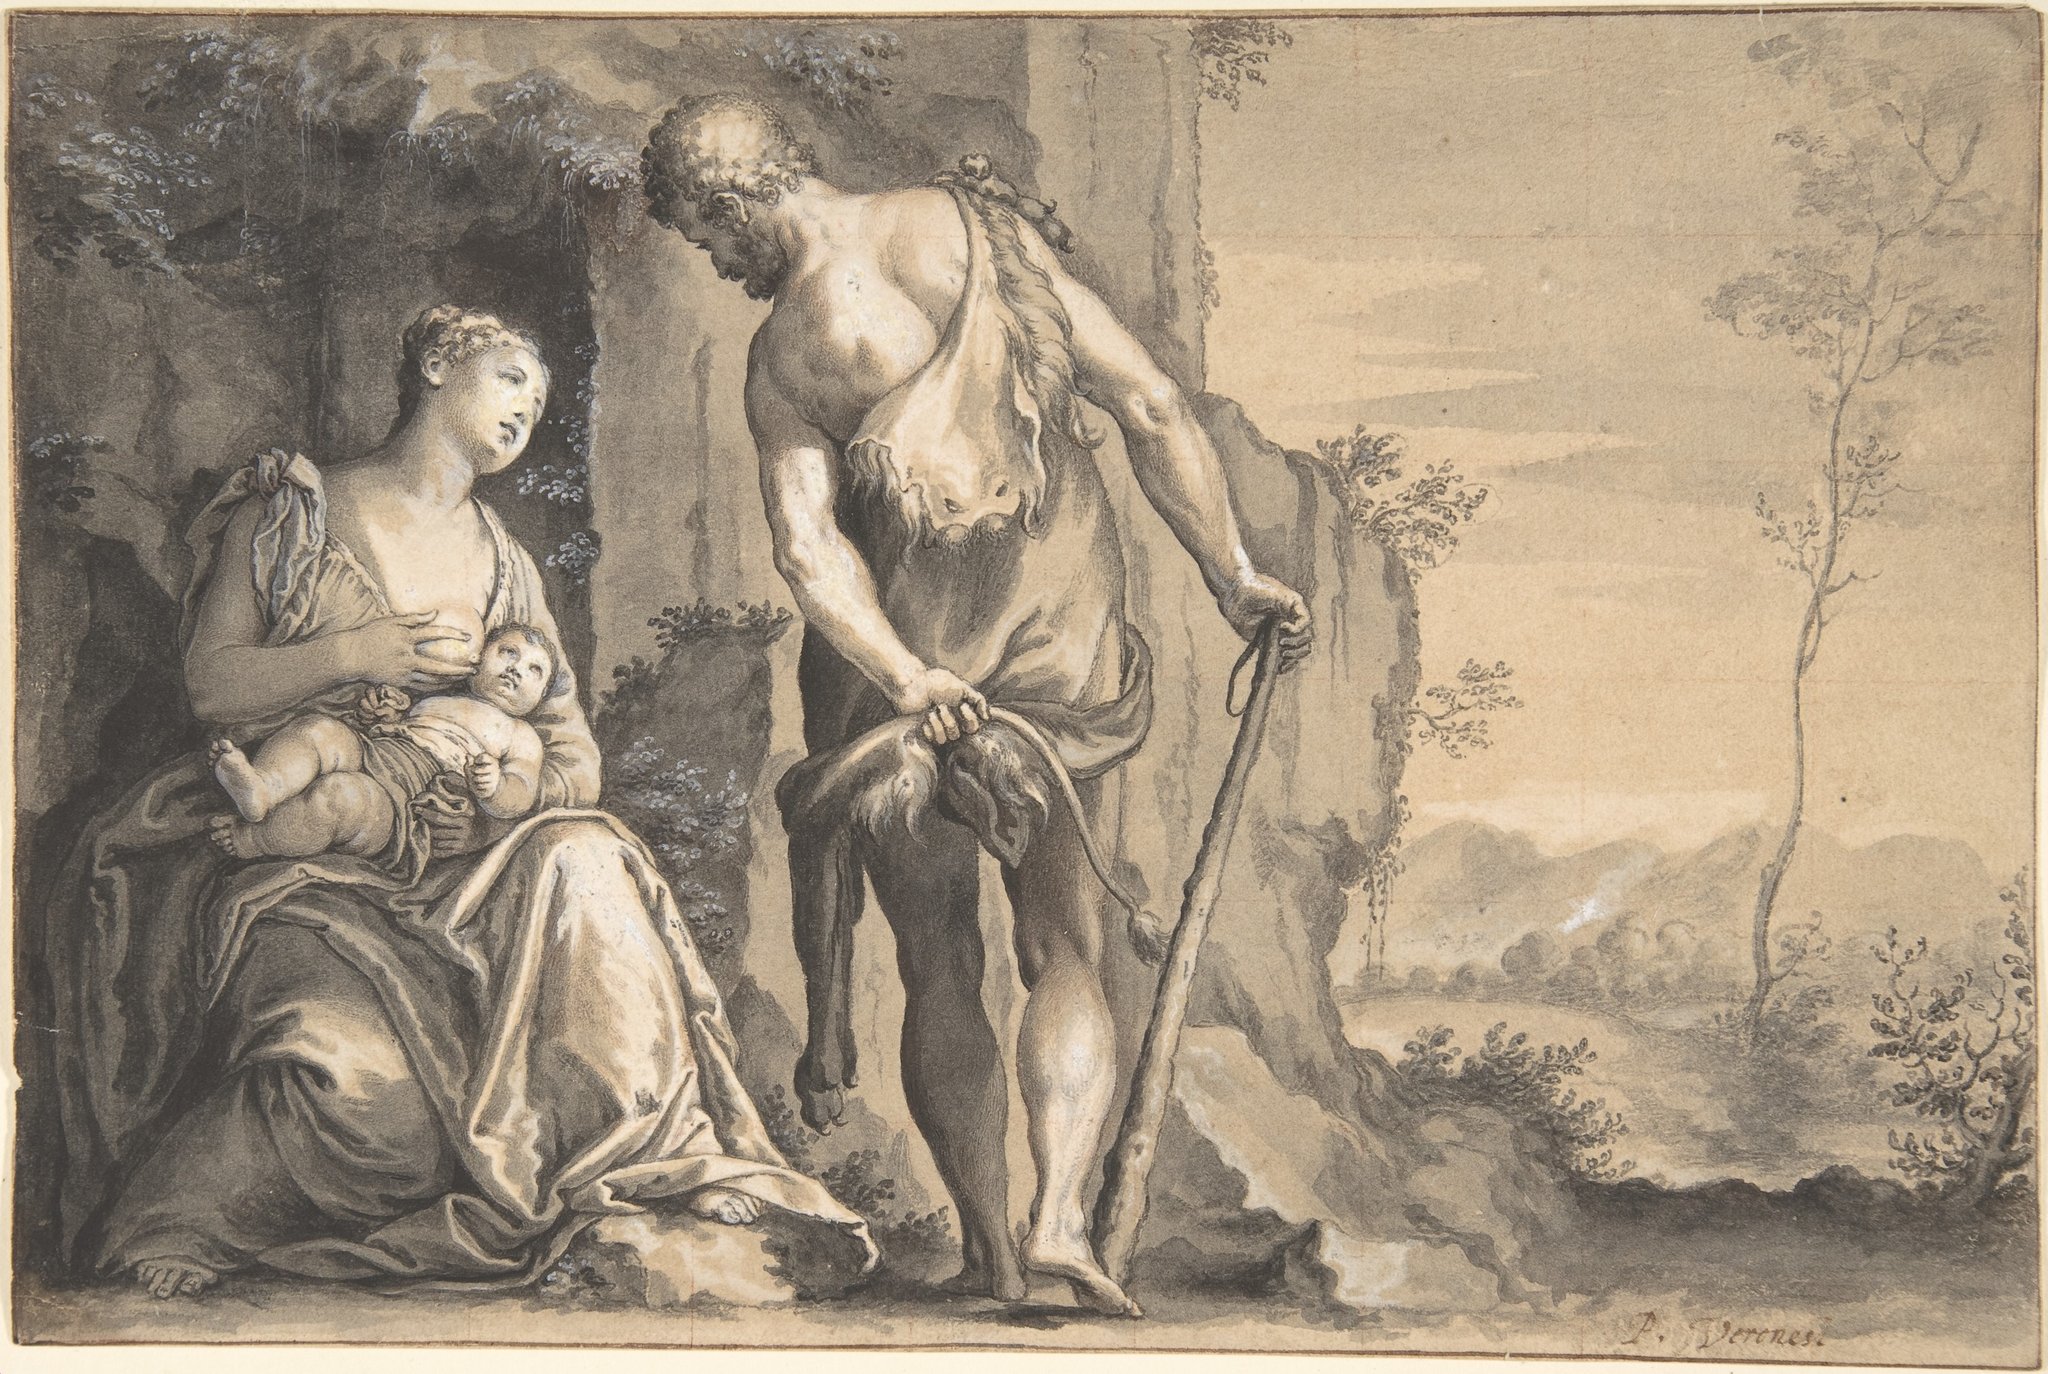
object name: drawing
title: The Family of Cain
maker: peter oliver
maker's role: artist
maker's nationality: british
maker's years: 1589-1647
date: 1638-1647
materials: chalk, gouache, ink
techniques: brush, highlighting, pen, wash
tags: infants,mothers,cain,family